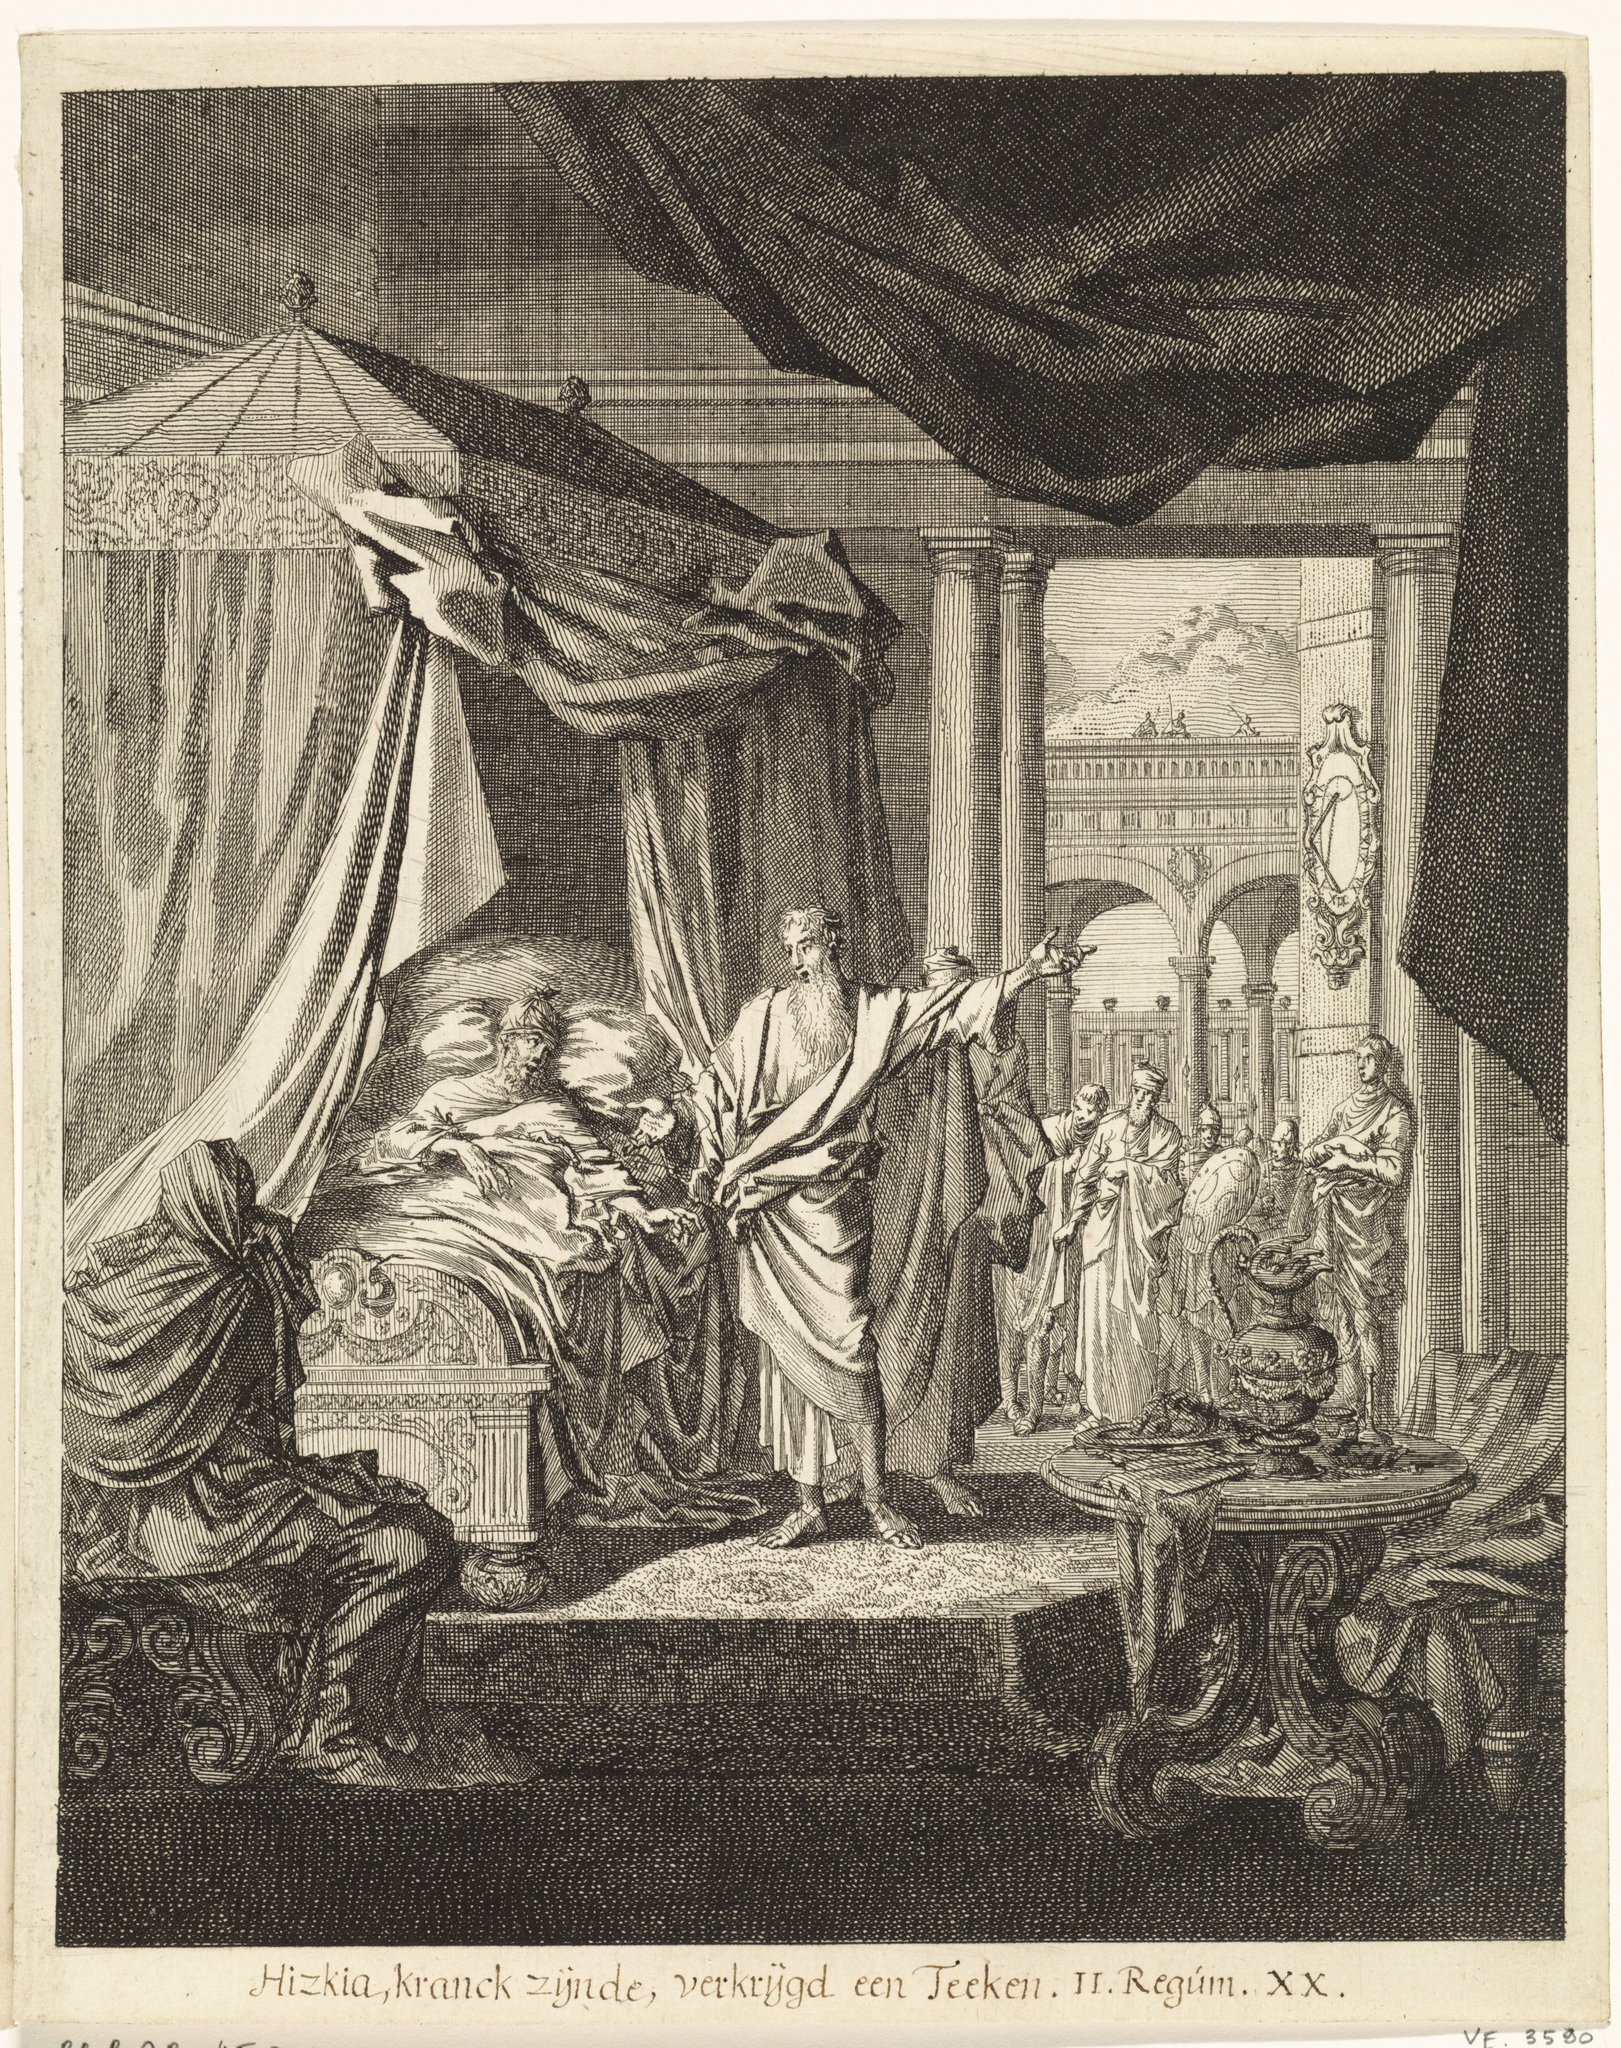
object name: print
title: Schaduw op zonnewijzer teruggezet voor Hizkia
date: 1708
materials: paper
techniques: etching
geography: amsterdam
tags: isaiah prays to god and the shadow of the sundial goes back ten degrees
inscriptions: collector's mark: Lugt 2228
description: Proefdruk van een prent welke is opgenomen als illustratie in: Historiae Celebriores Veteris Testamenti. Christoph Weigel, 1708.